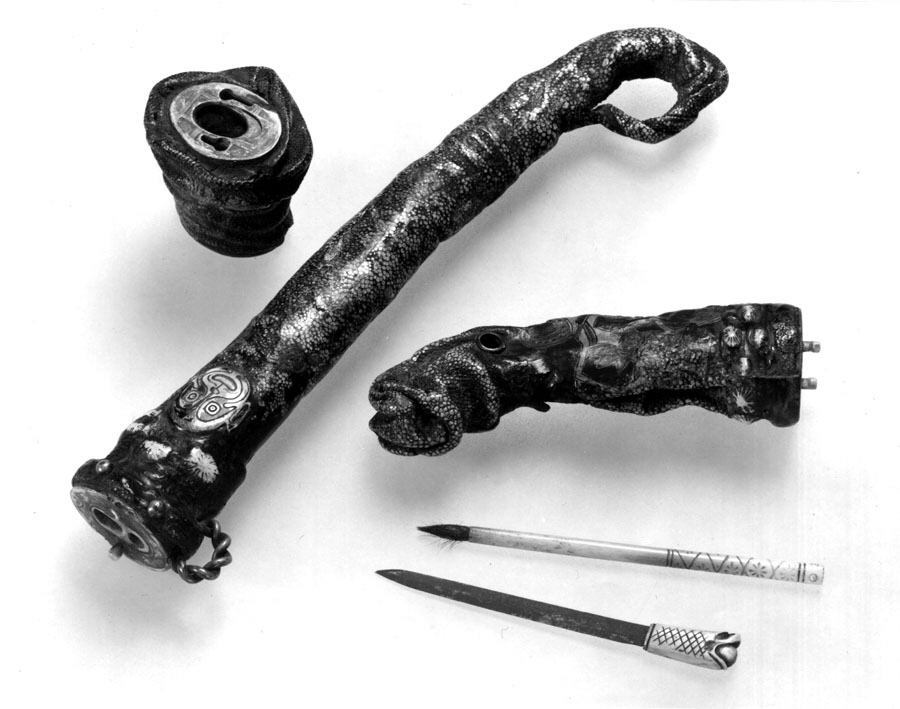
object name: portable writing set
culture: indonesian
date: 1801-1900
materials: ivory